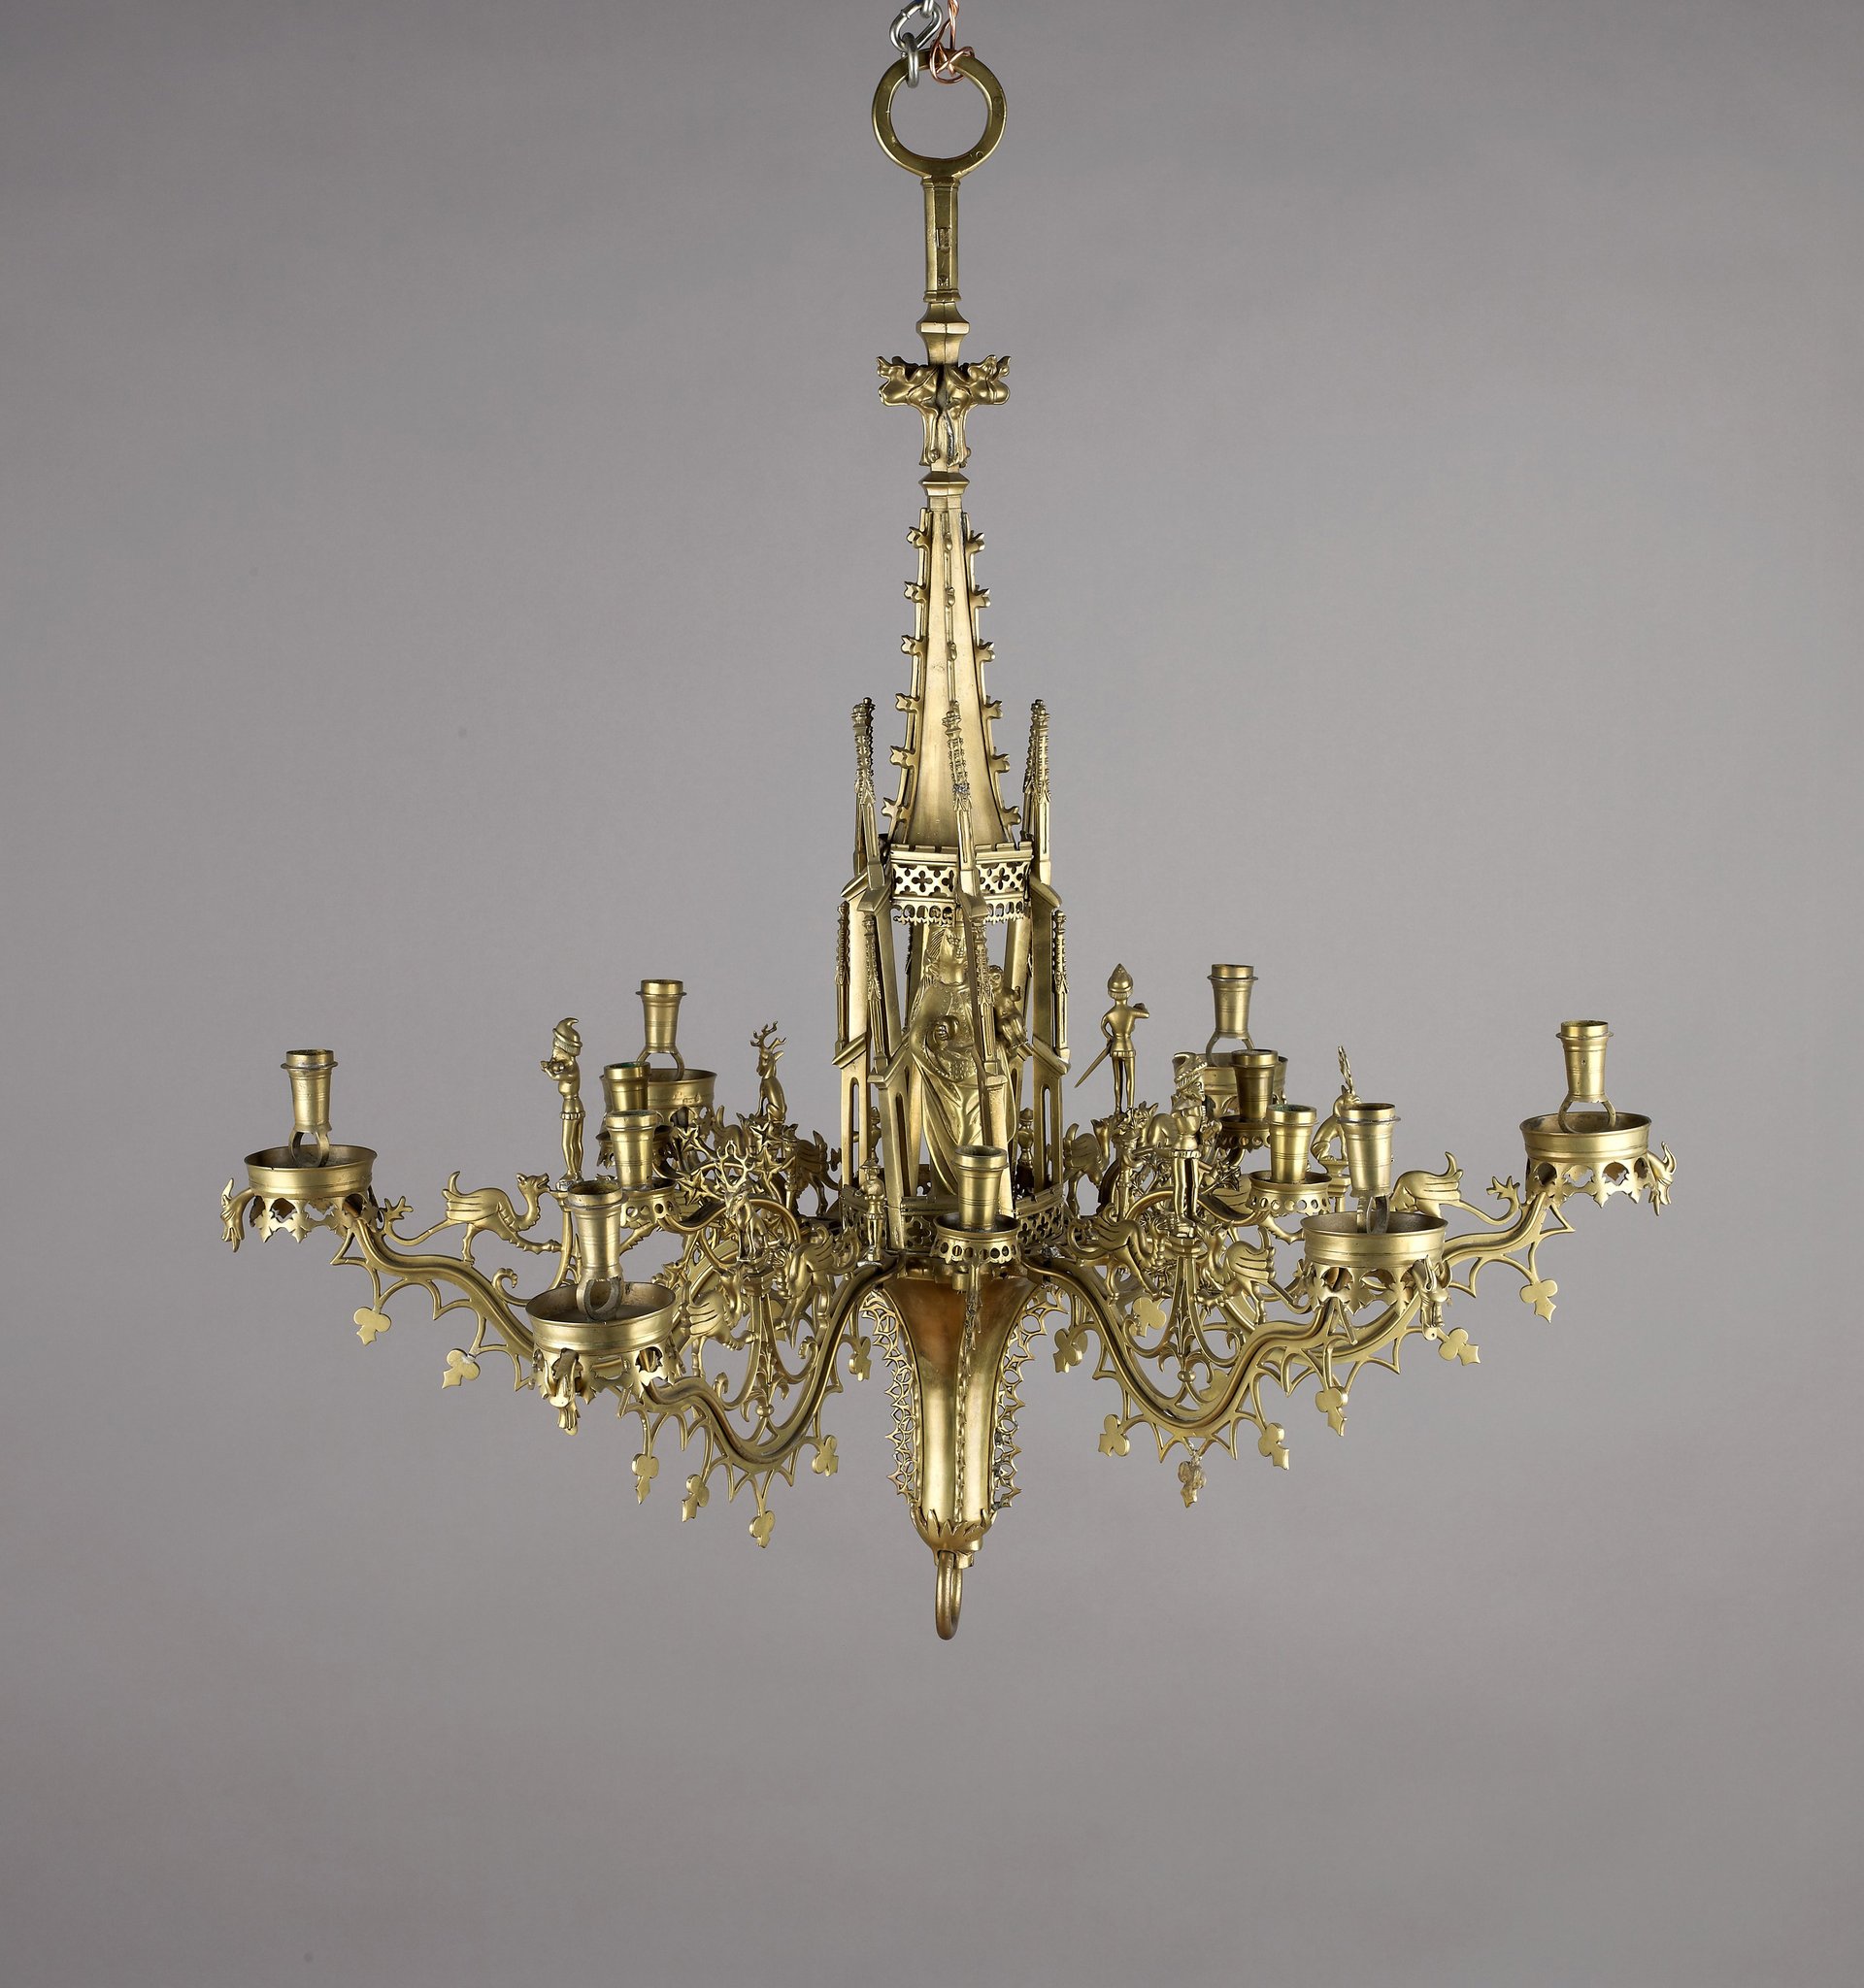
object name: chandelier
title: Chandelier with tabernacle (Kapellenkrone)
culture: german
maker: f. ring foundry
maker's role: artist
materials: brass